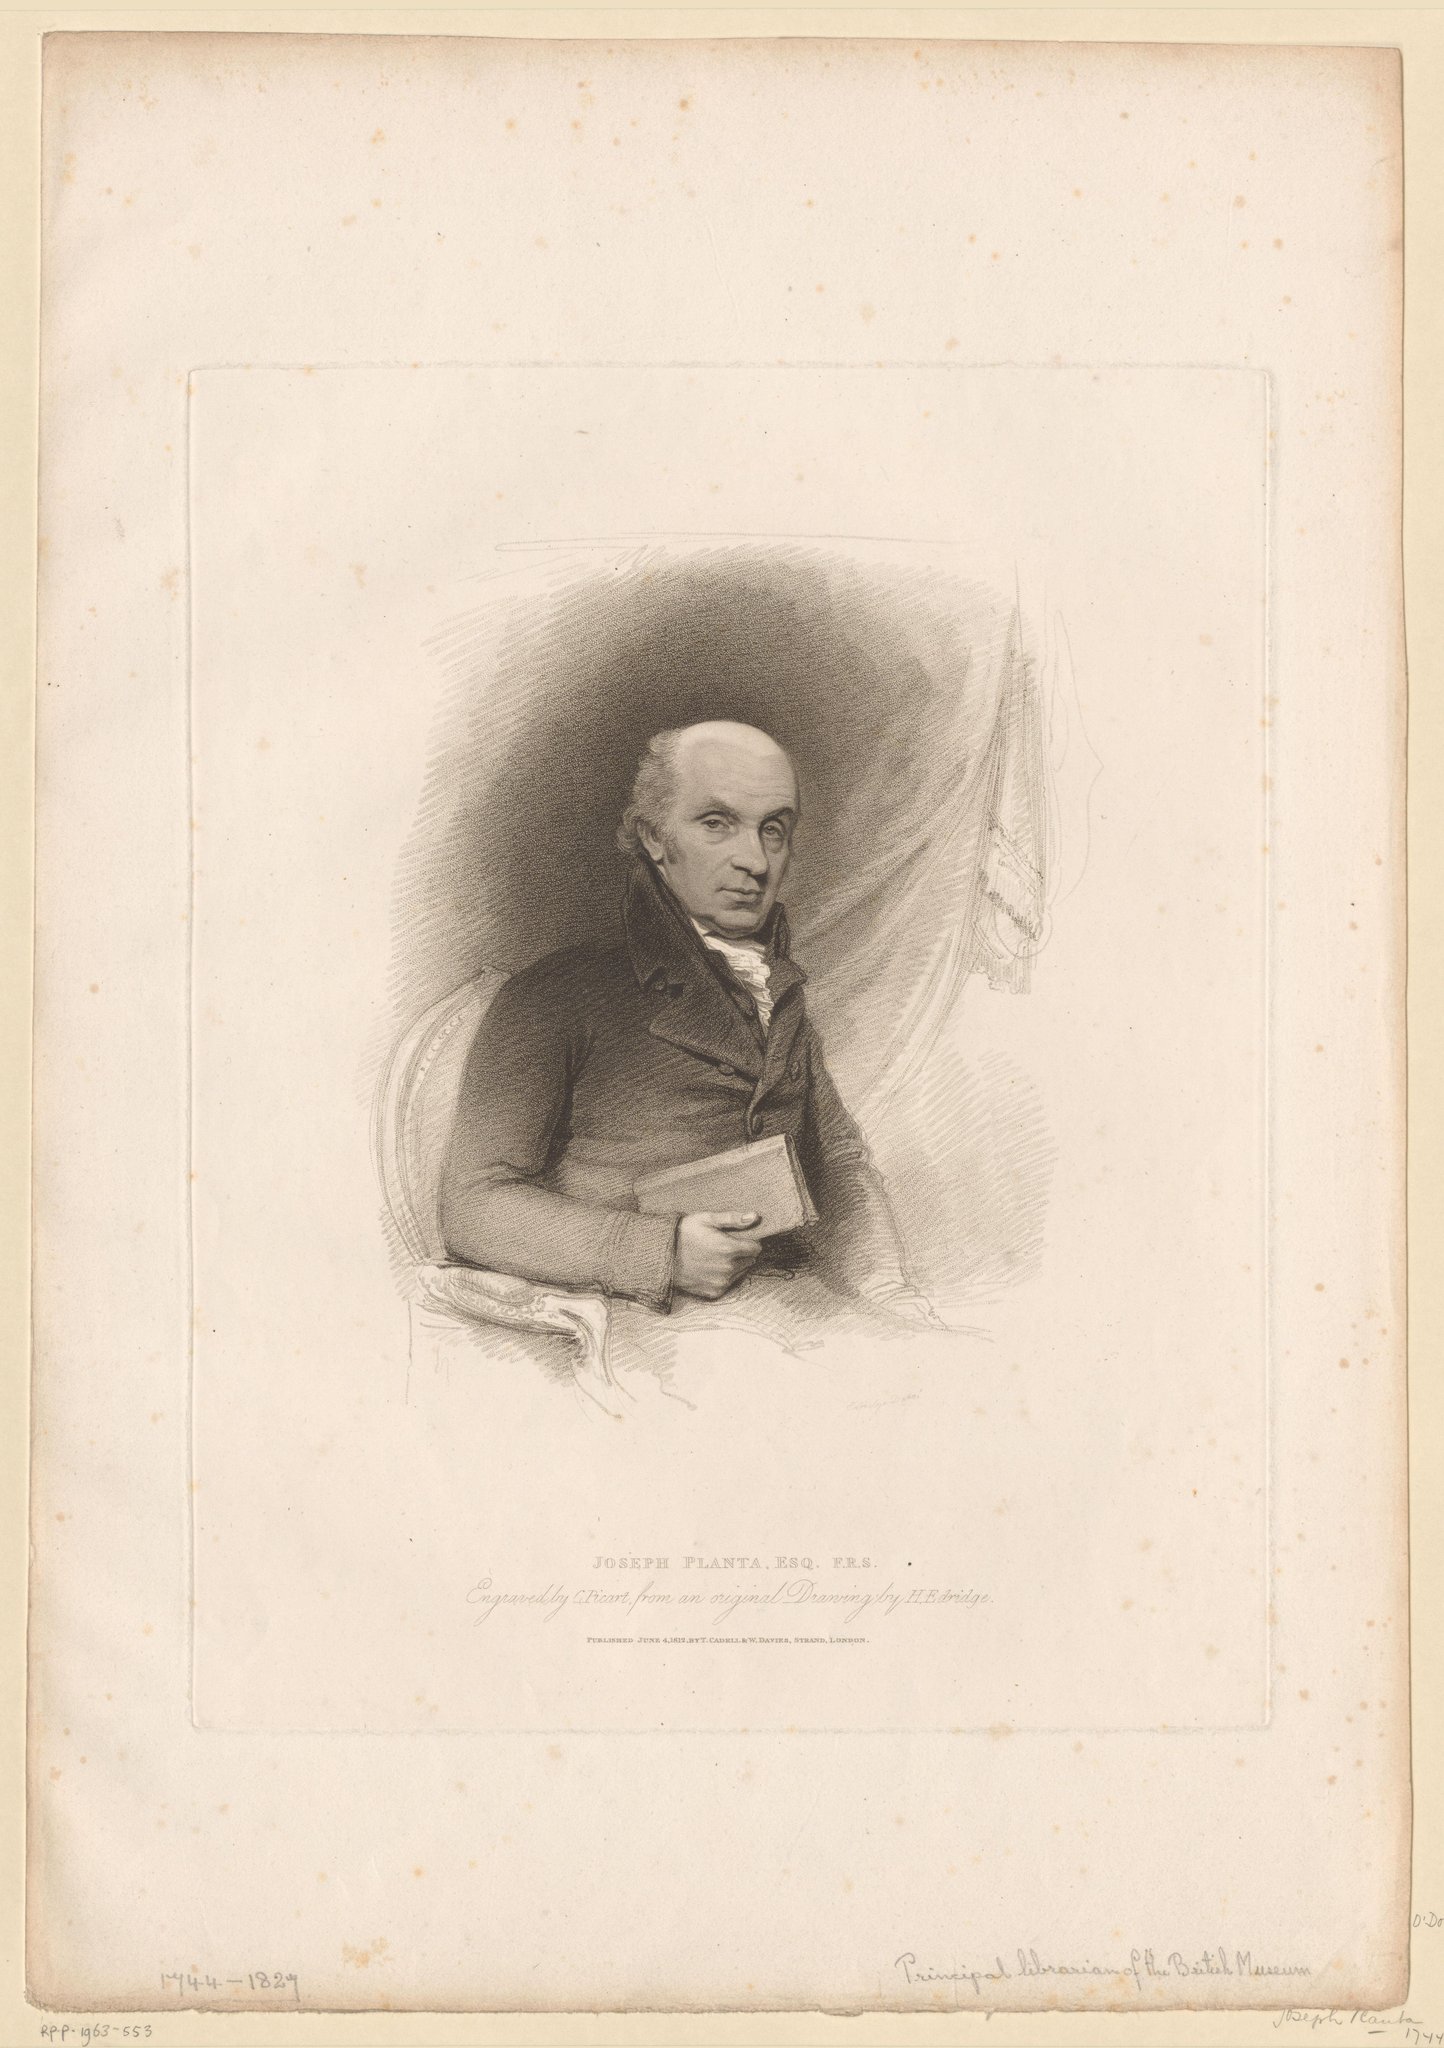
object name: print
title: Britse portretten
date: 1812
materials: paper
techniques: engraving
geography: london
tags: adult man, historical persons, book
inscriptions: collector's mark: Lugt 2228